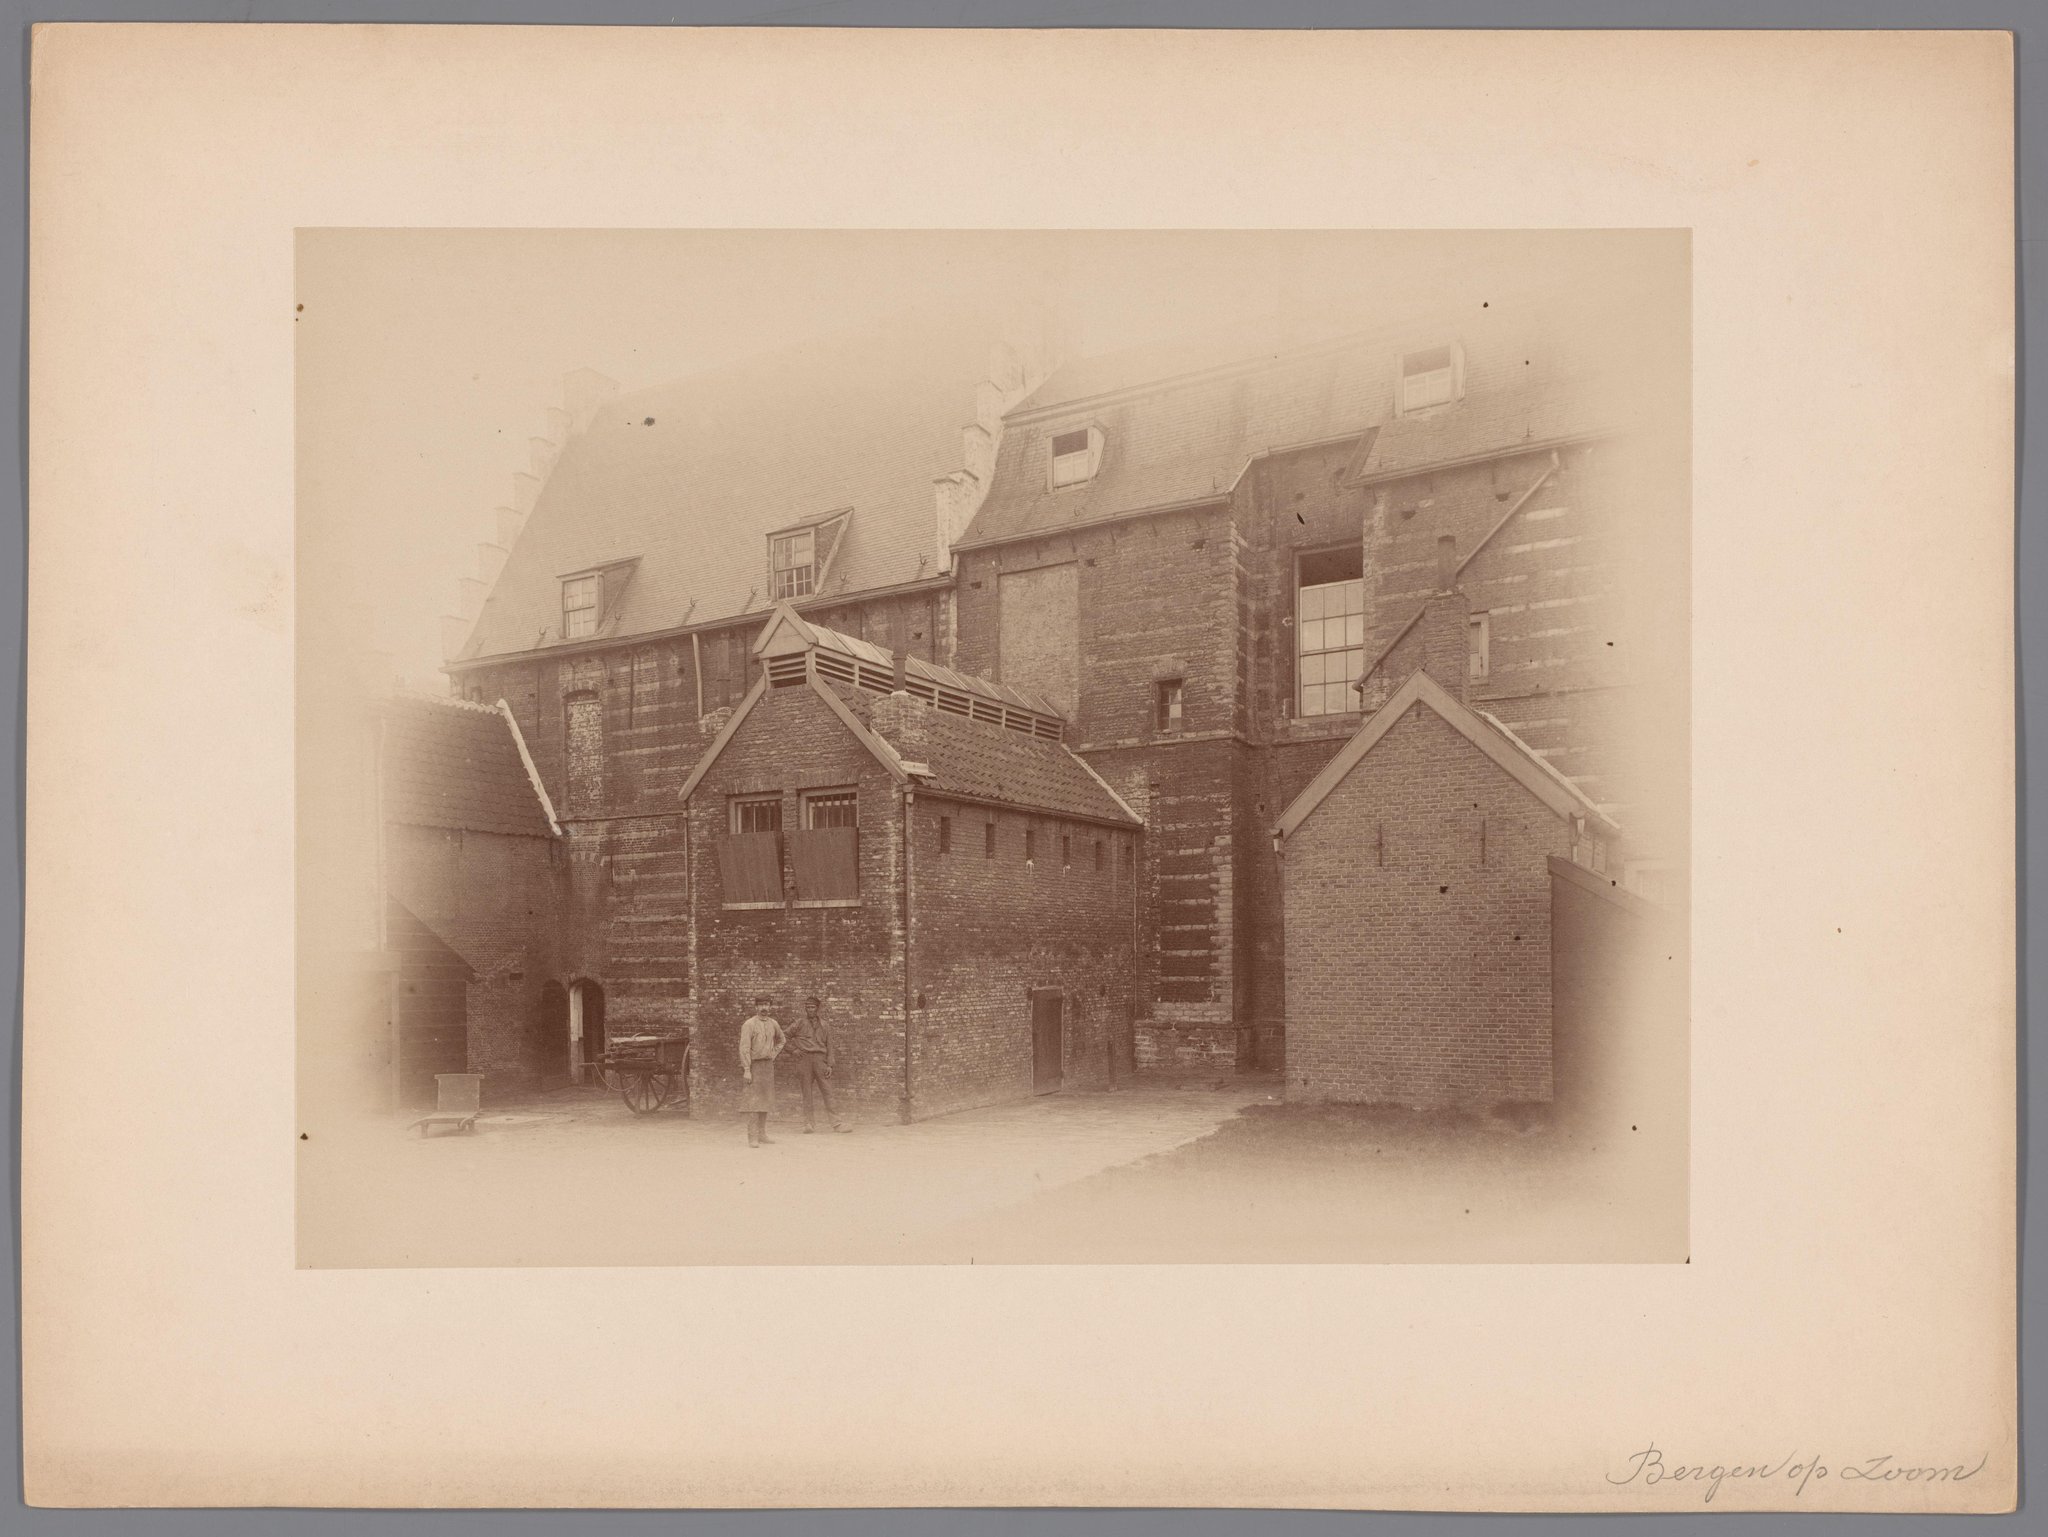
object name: photograph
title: Achterplaats van het Markiezenhof te Bergen op Zoom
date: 1890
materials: cardboard, photographic support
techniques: albumen print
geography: markiezenhof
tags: hôtel, i.e. small palace in city, bergen op zoom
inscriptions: annotation: ‘Bergen op Zoom’, annotation: ‘Markiezenhof te Bergen-op-Zoom. / gezicht op de achterplaats / sept 1890/ NB A-B’